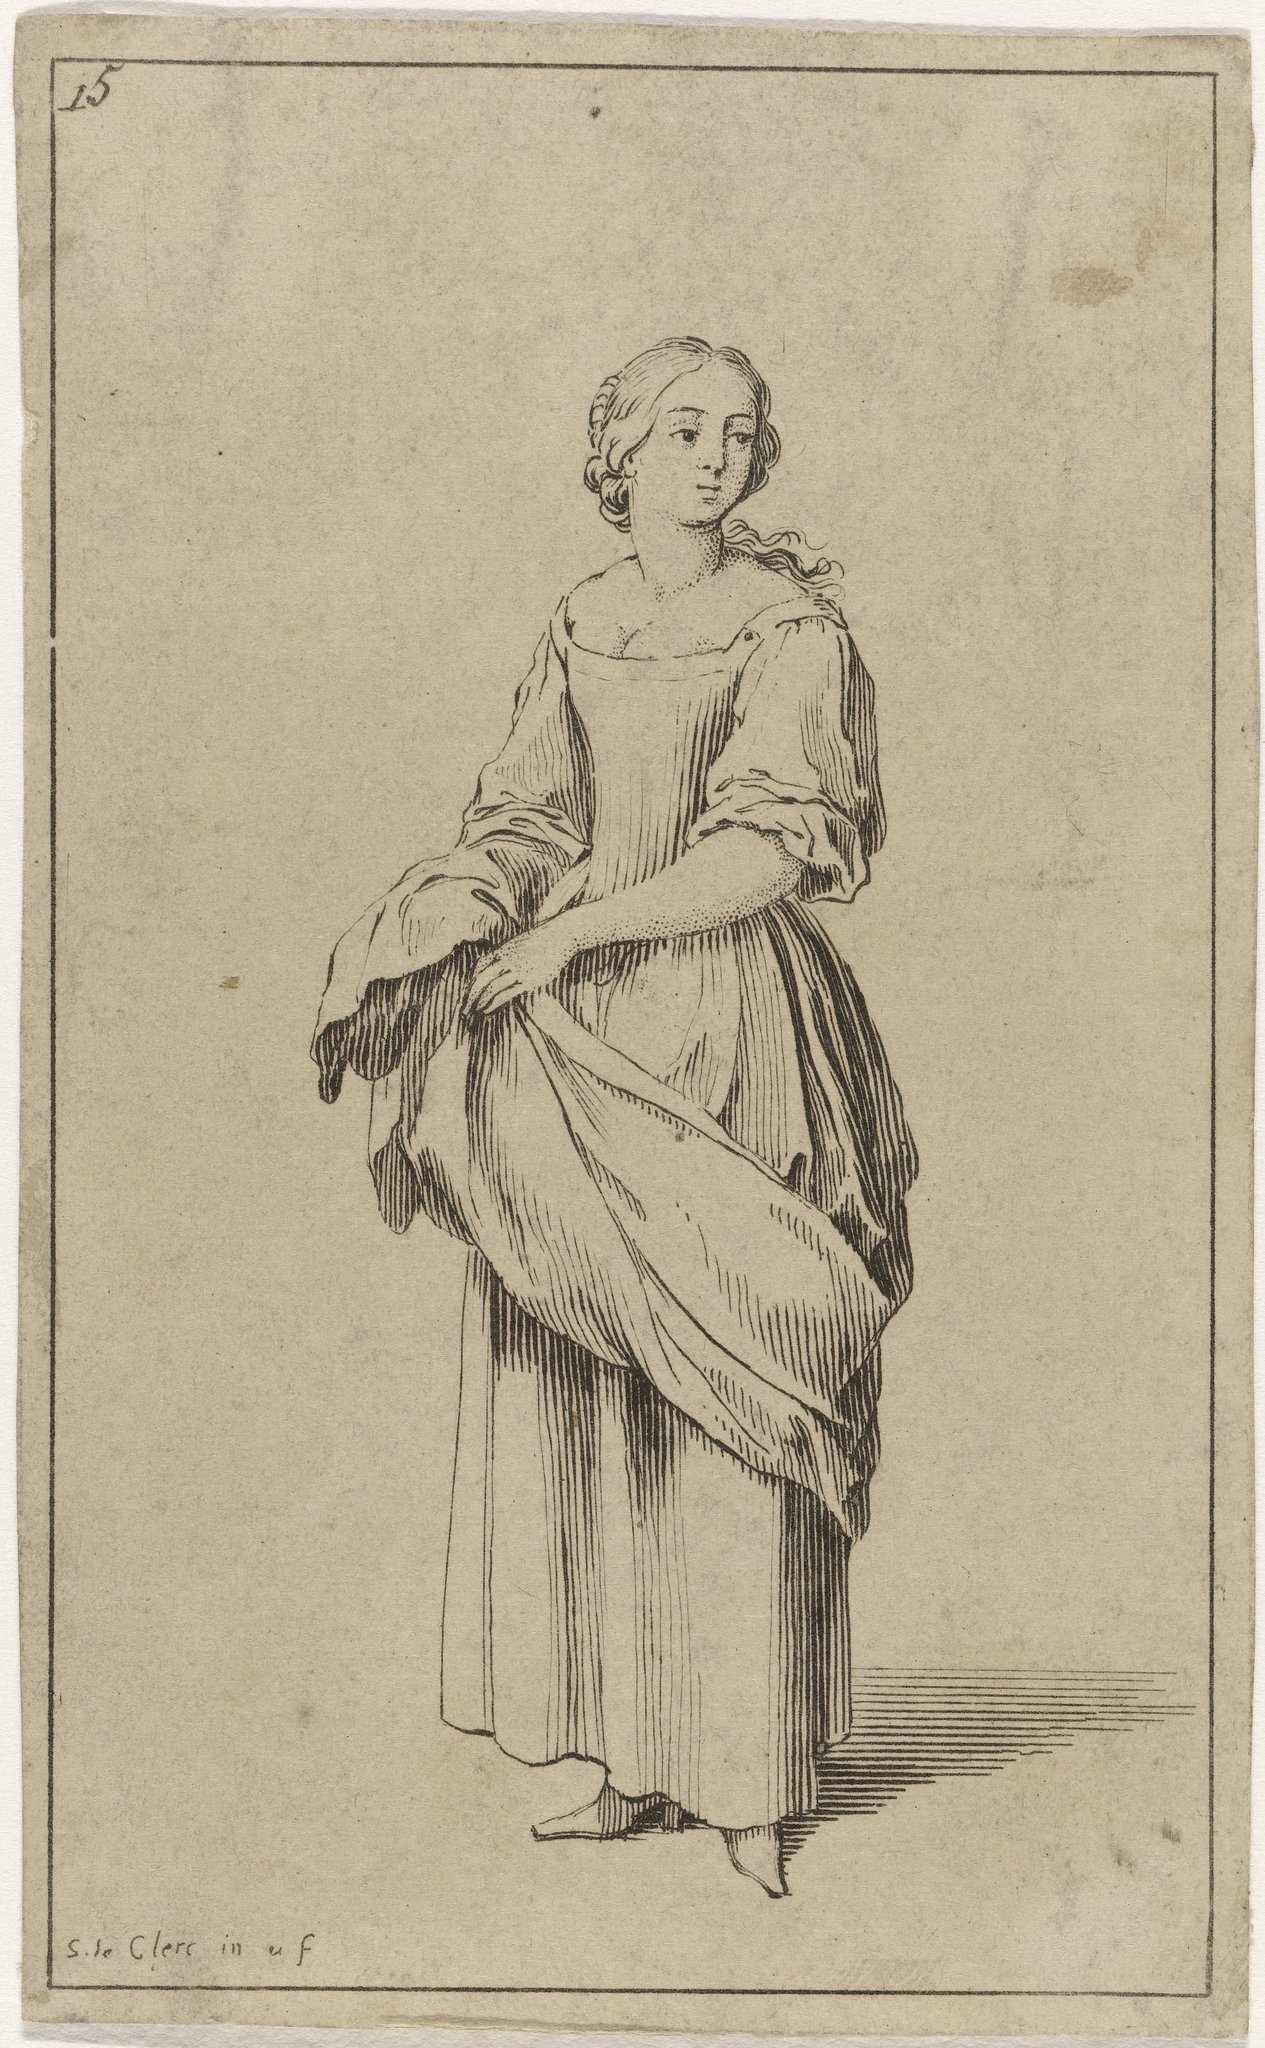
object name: print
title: Figures a la mode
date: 1685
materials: paper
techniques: etching